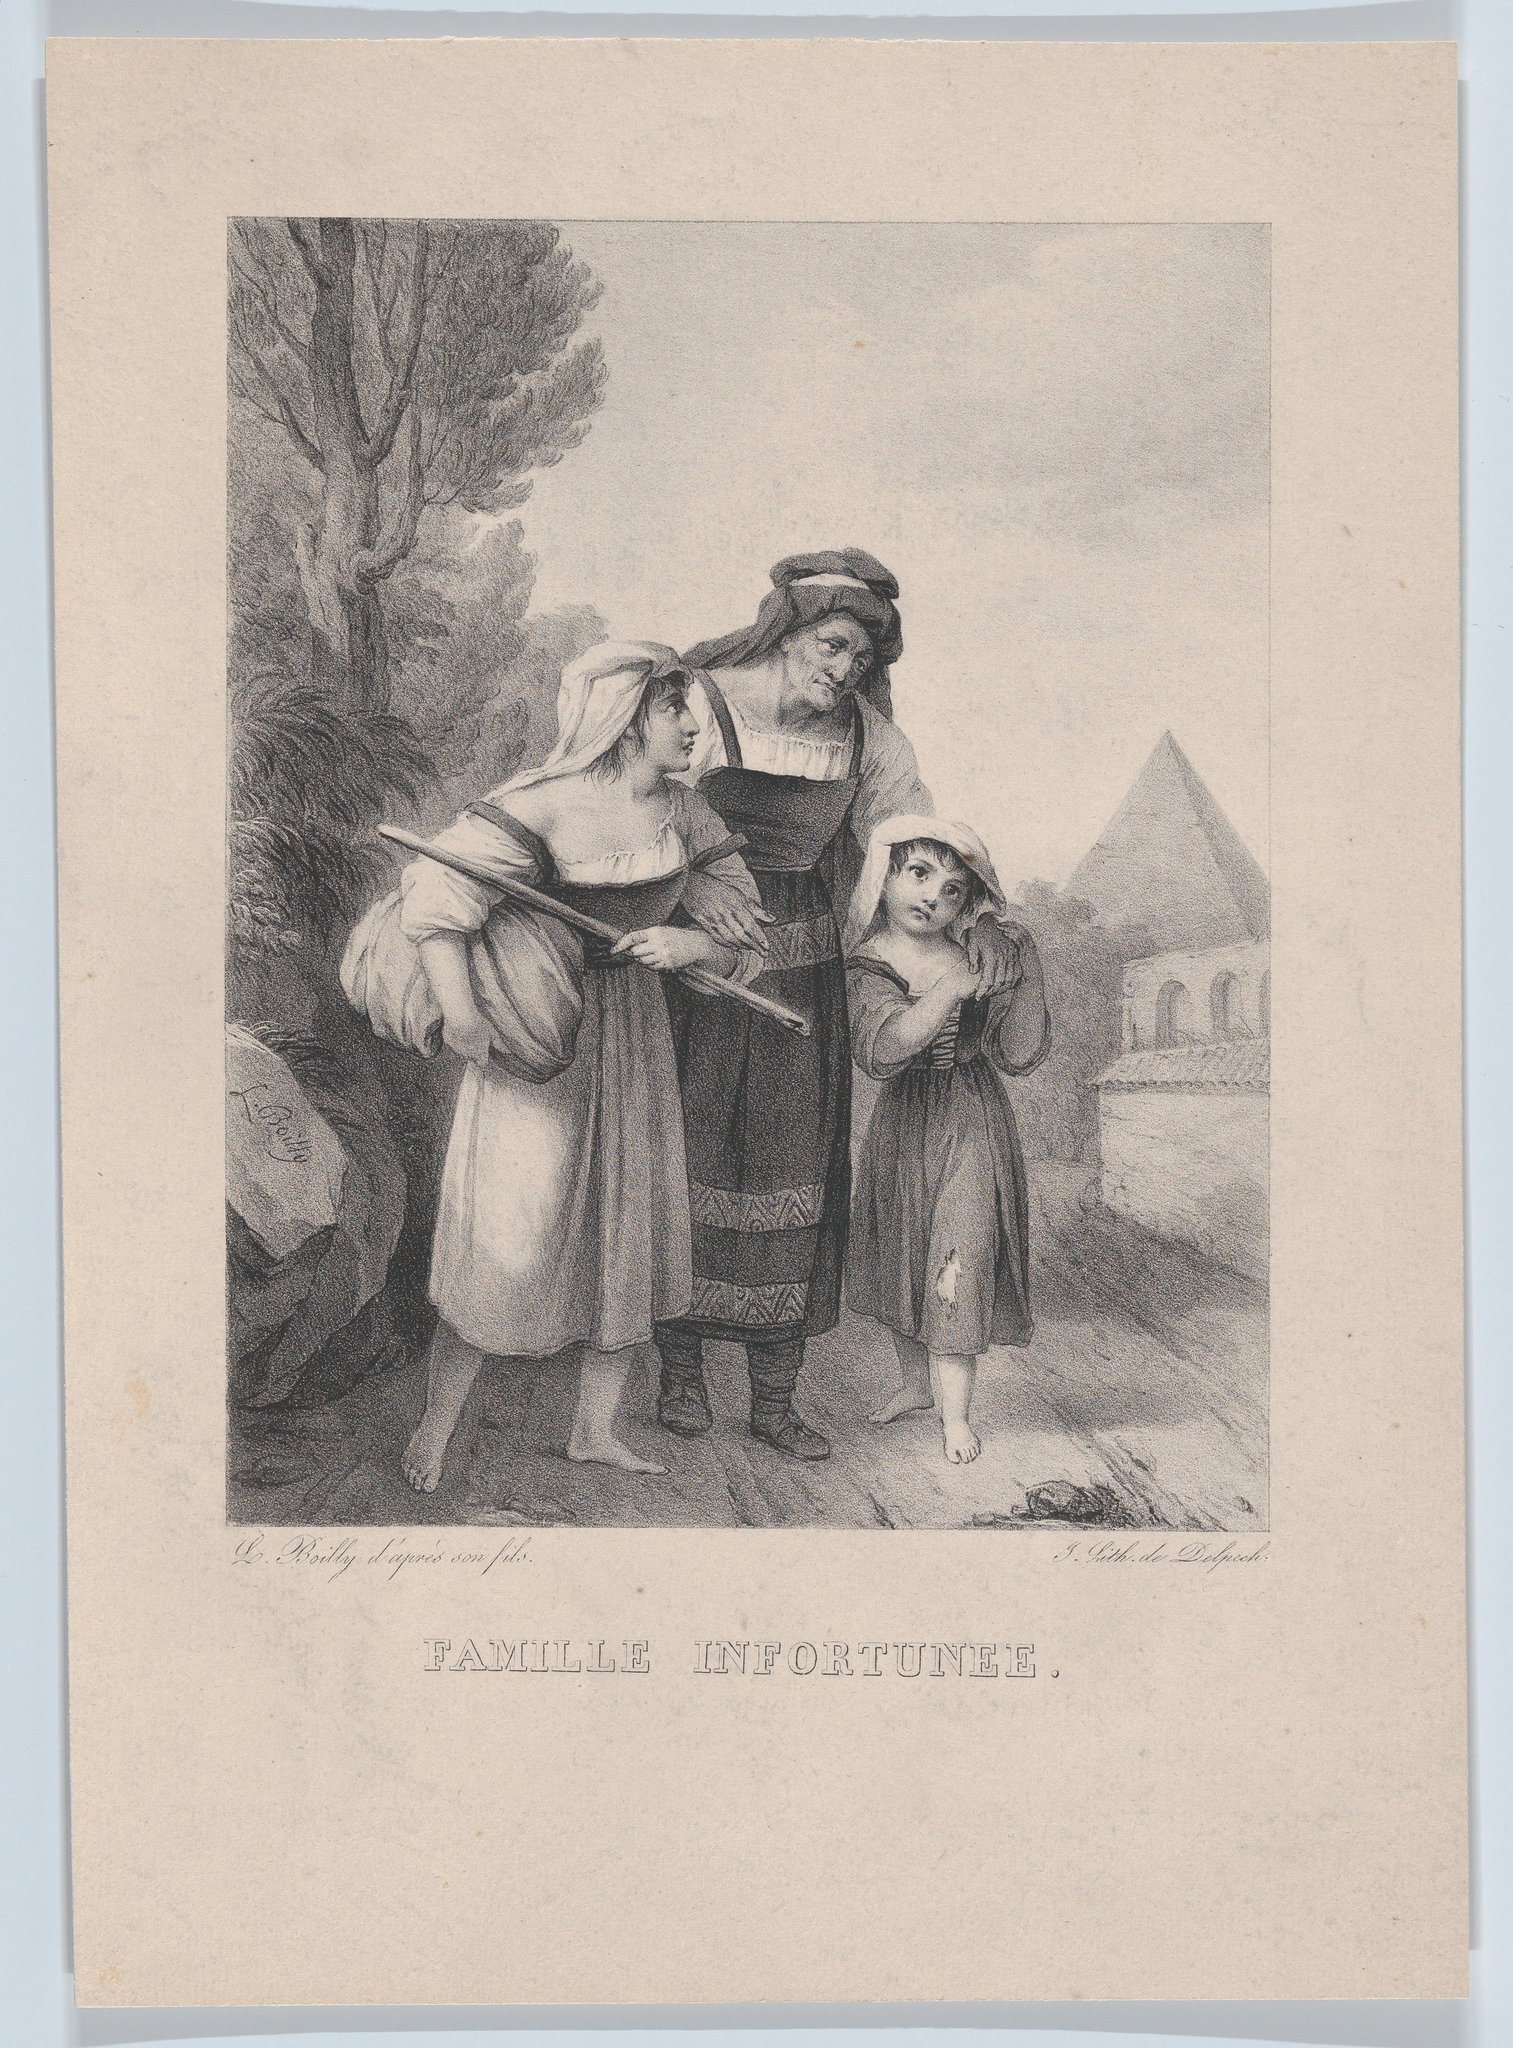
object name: print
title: The Ill-Fated Family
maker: louis léopold boilly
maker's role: artist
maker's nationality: french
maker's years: 1761-1845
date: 1826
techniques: lithograph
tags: girls,women,family